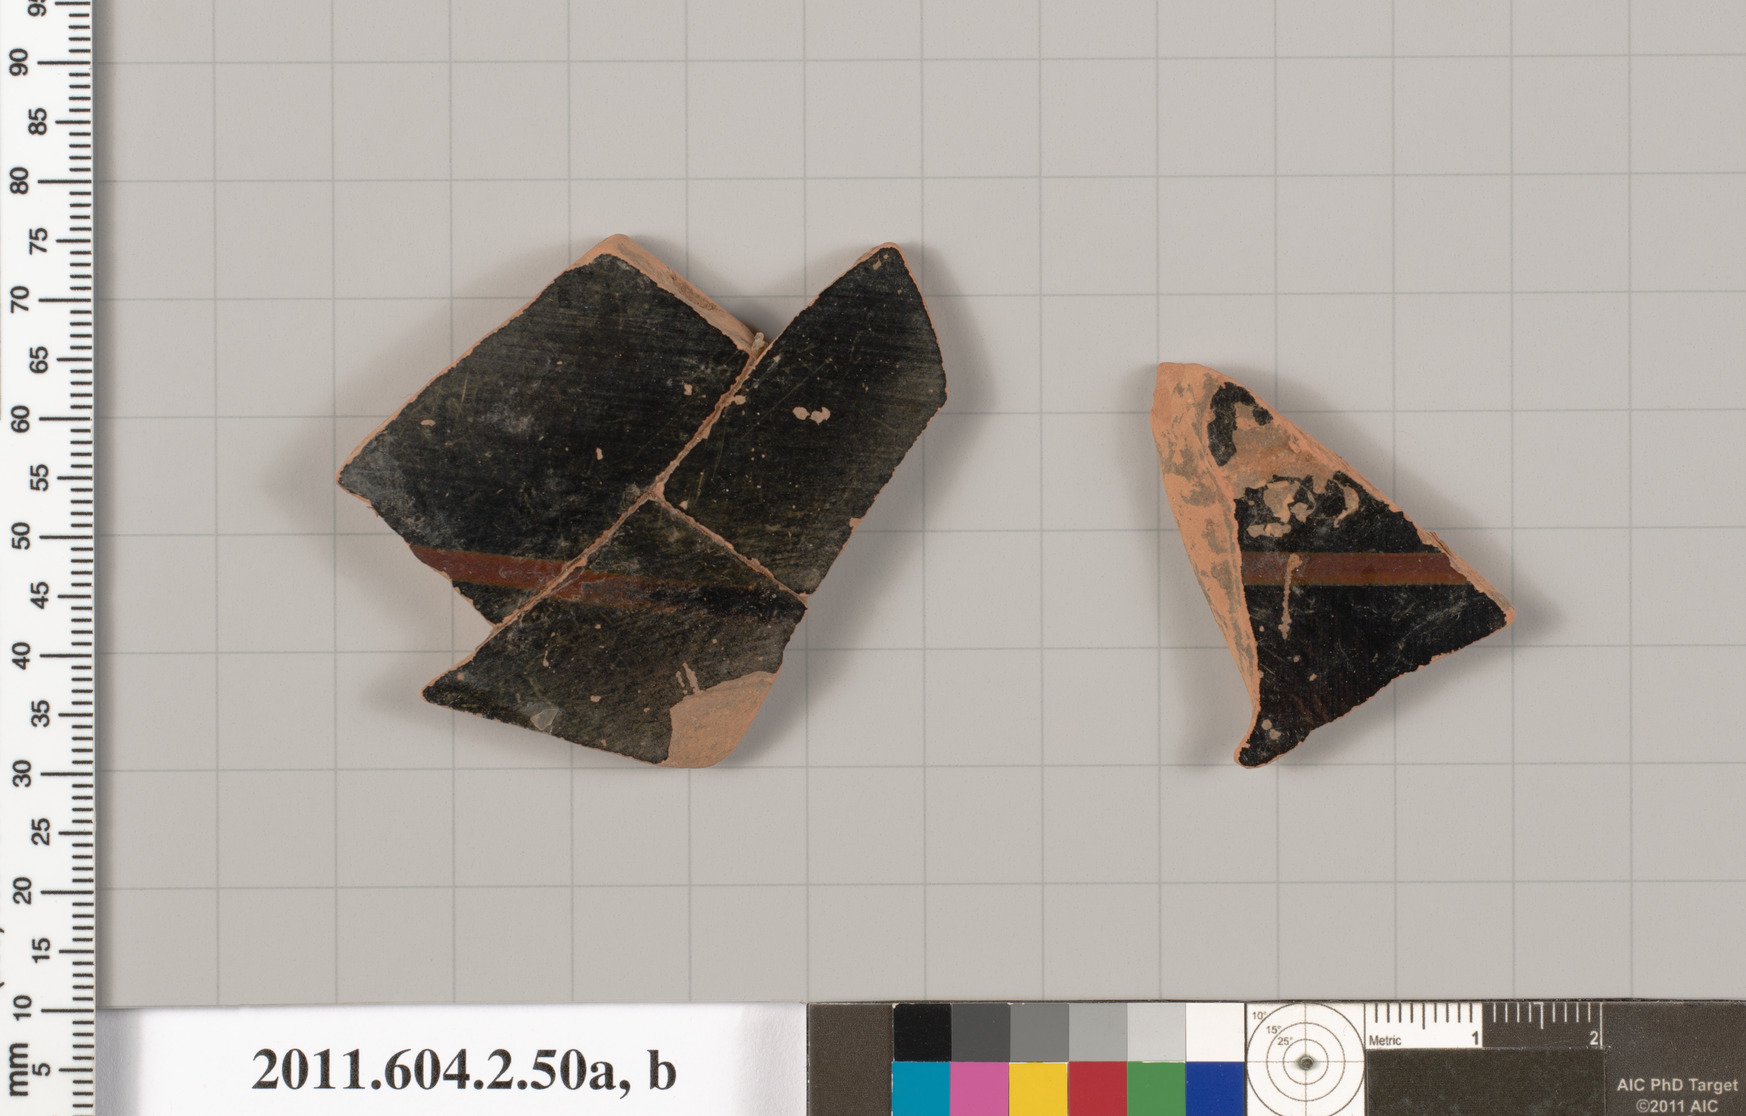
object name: pelike fragment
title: Terracotta fragments of a pelike (jar)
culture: greek, attic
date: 510-480 BCE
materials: terracotta